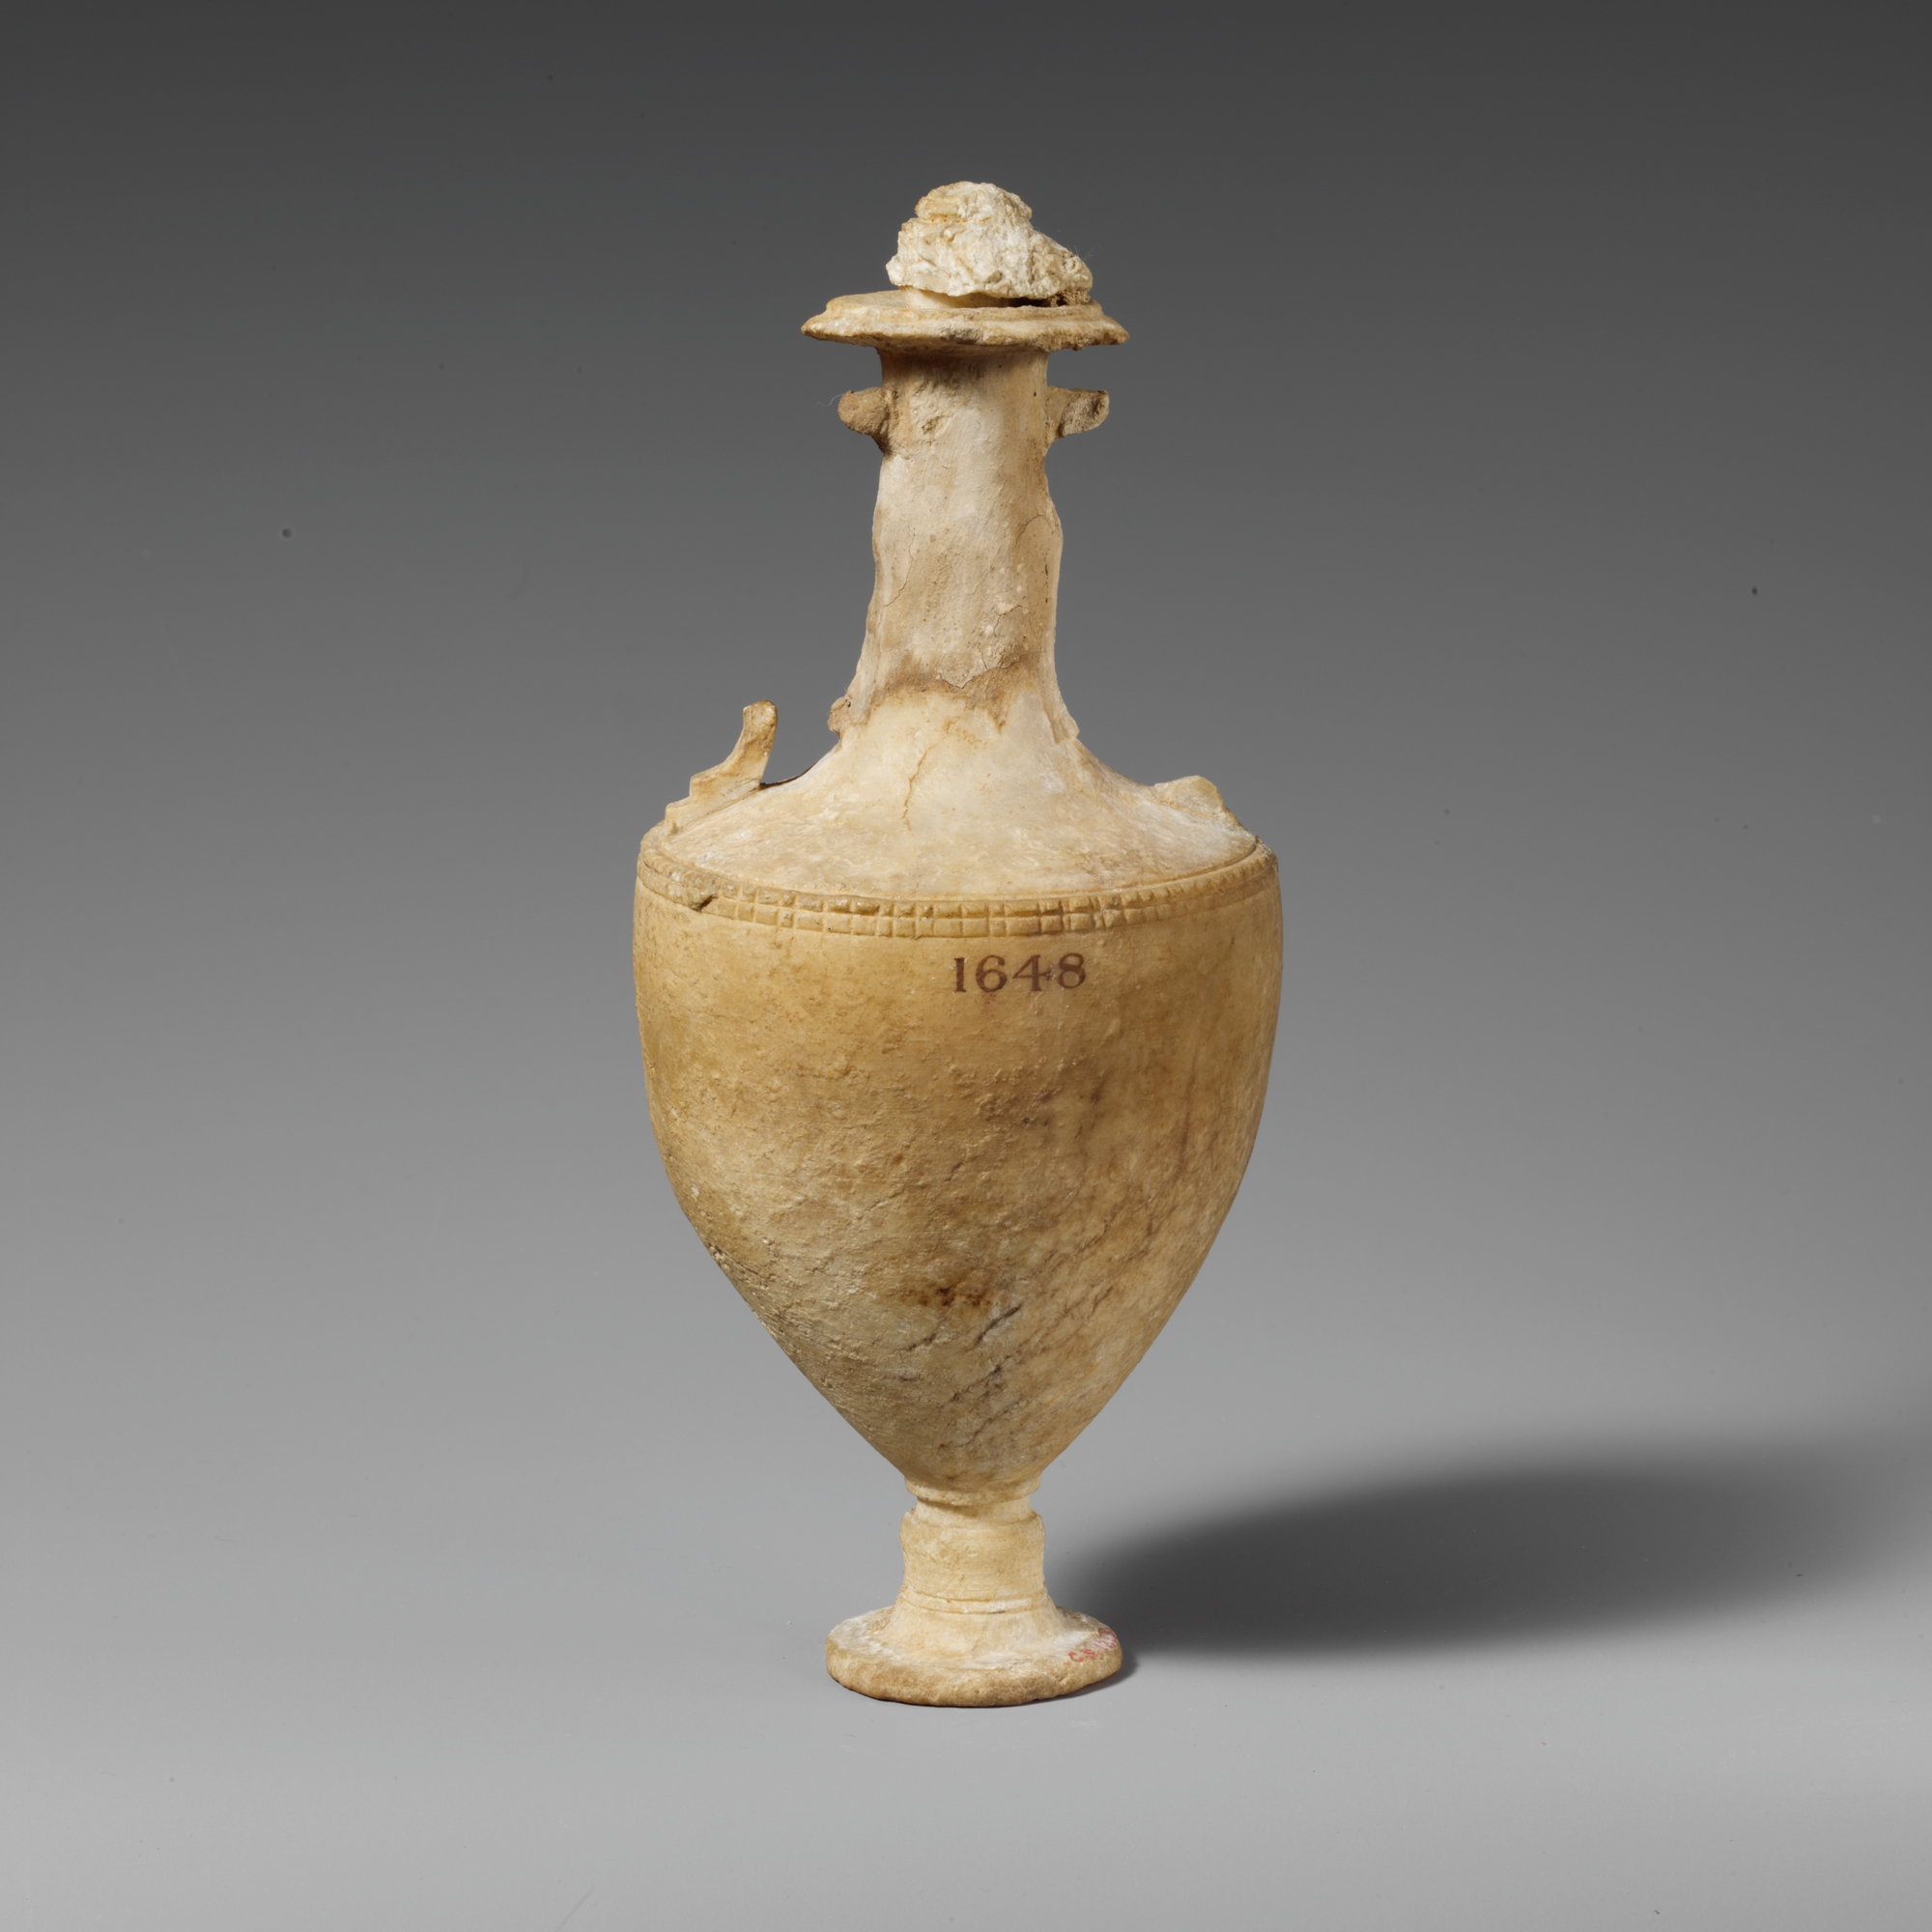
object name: vase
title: Alabaster or loutrophoros (jar for storage or water)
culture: cypriot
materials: alabaster